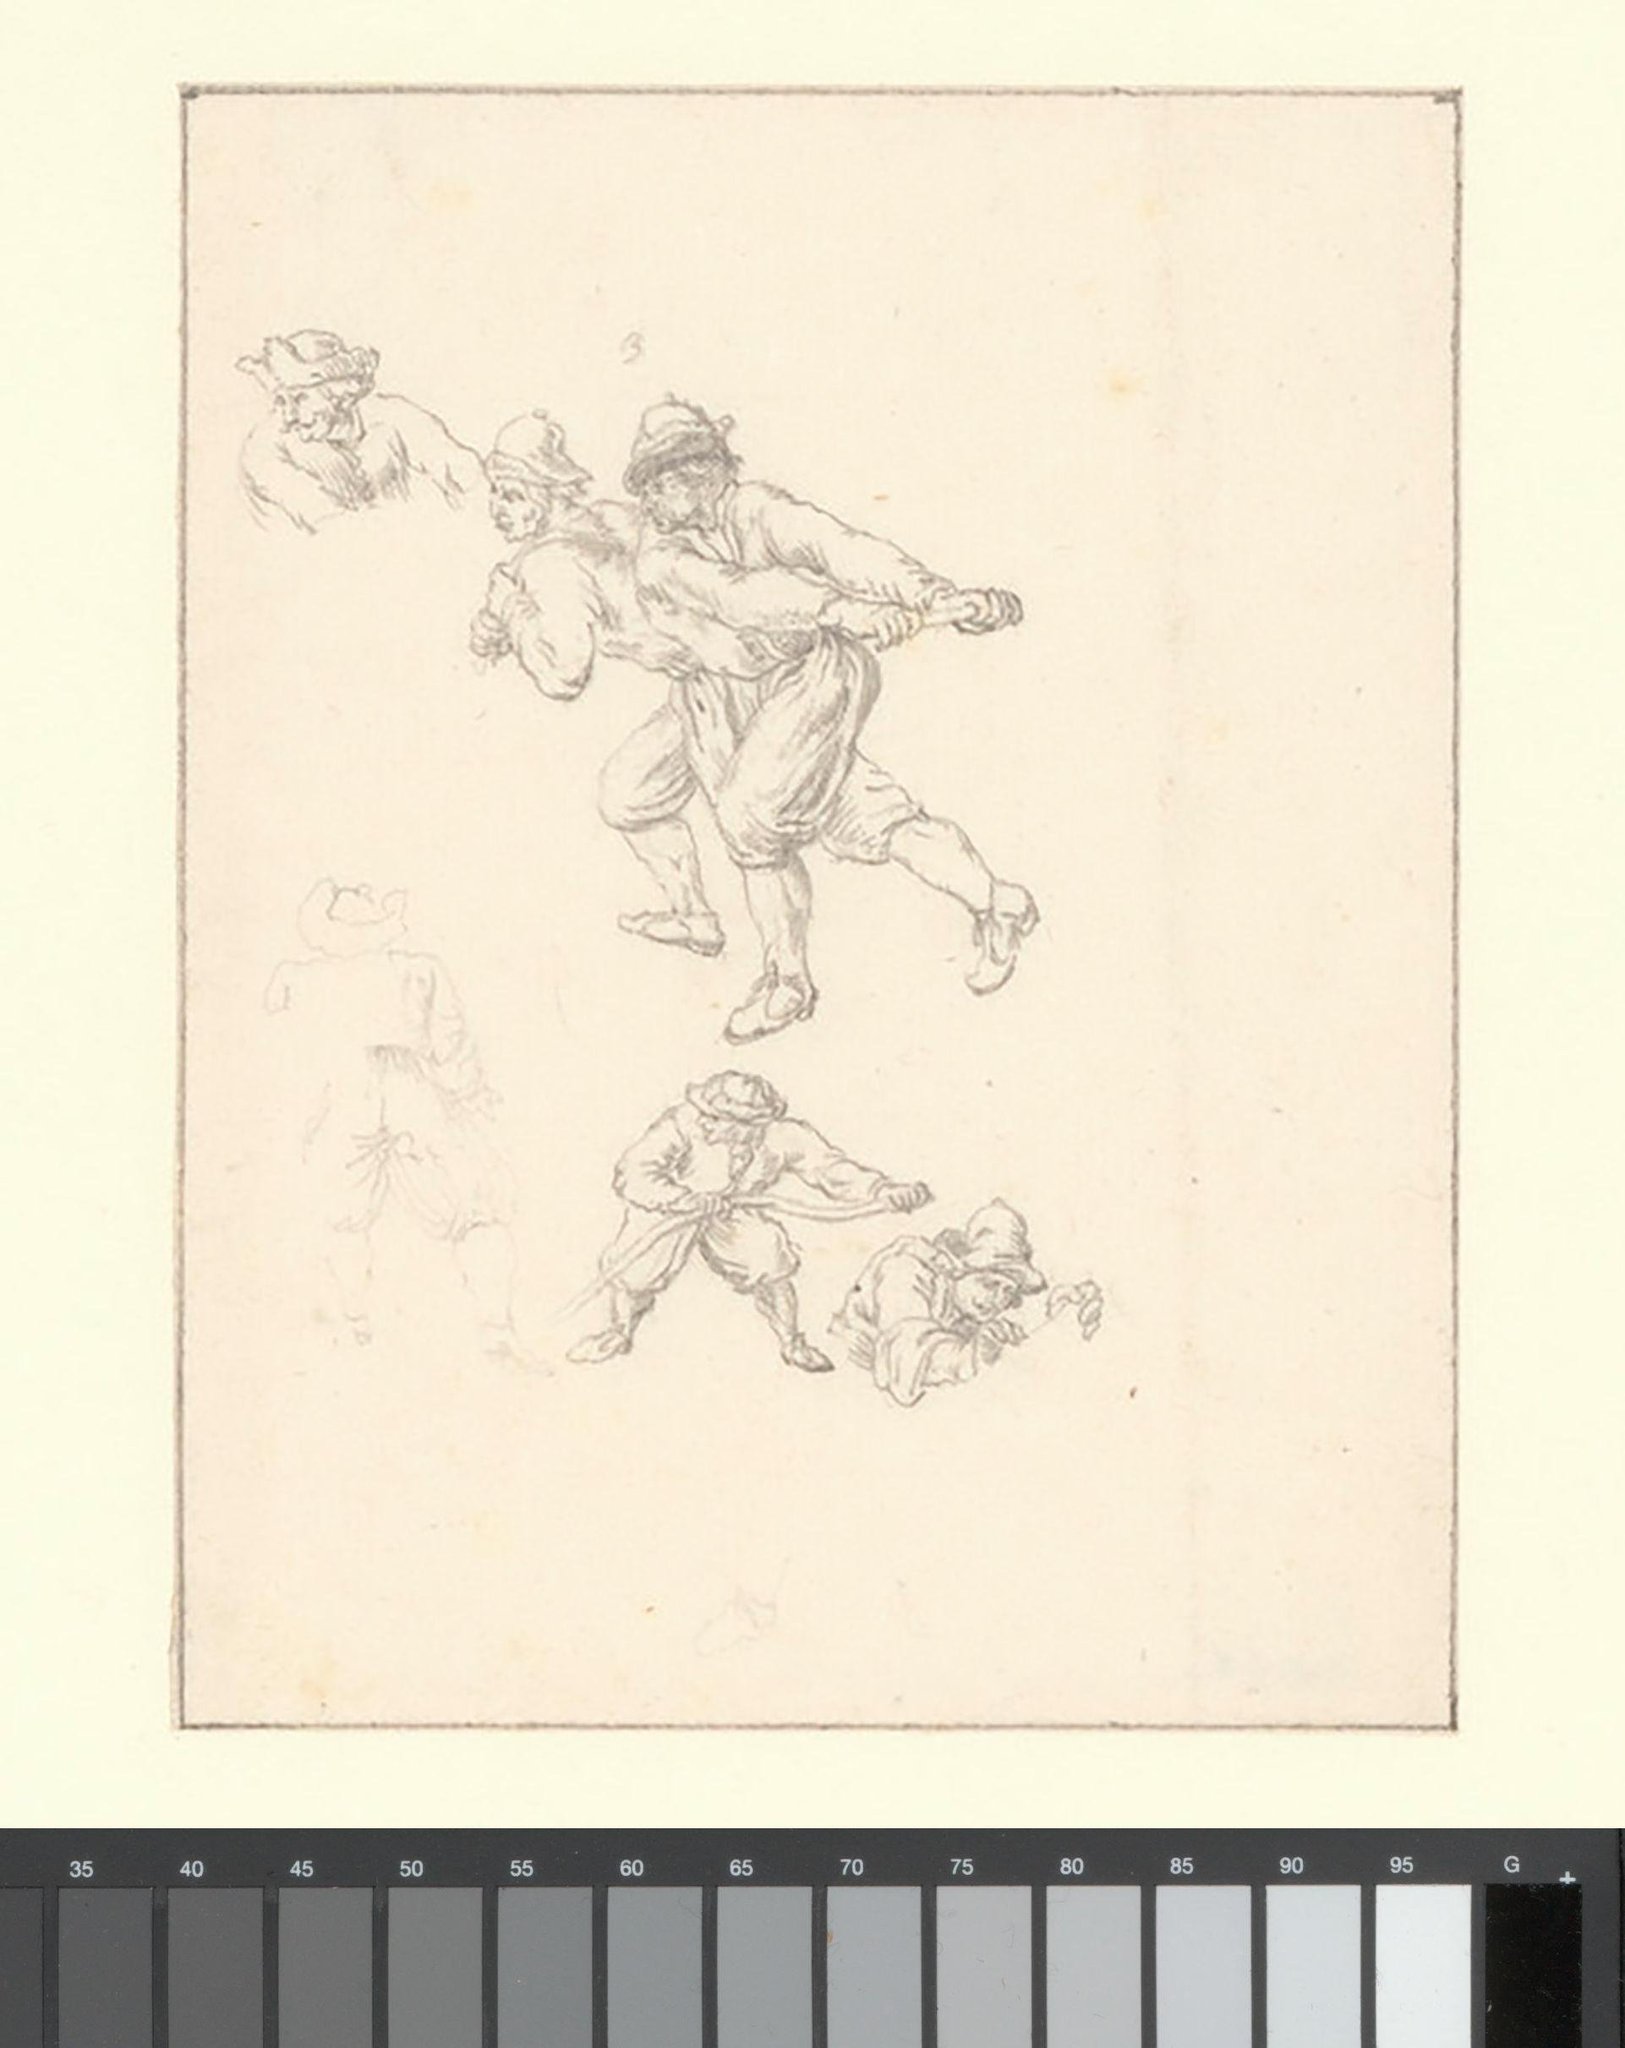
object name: drawing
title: Compositie met zes brandweermannen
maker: jan van der heyden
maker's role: draughtsman, painter, print maker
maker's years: 1637-1712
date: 1647-1690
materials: paper, pencil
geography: amsterdam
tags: firemen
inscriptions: name: ‘854 / vdHeiden’, collector's mark: ‘22’ Lugt 1641b, inscription: ‘Port. 22’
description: Ontwerptekening voor illustraties uit: Heyden, Jan van der. Beschryving der nieuwlyks uitgevonden en geoctrojeerde slang-brandspuiten, en haare wyze van brand-blussen (...). Amsterdam: Jan Rieuwertsz (II), 1690.